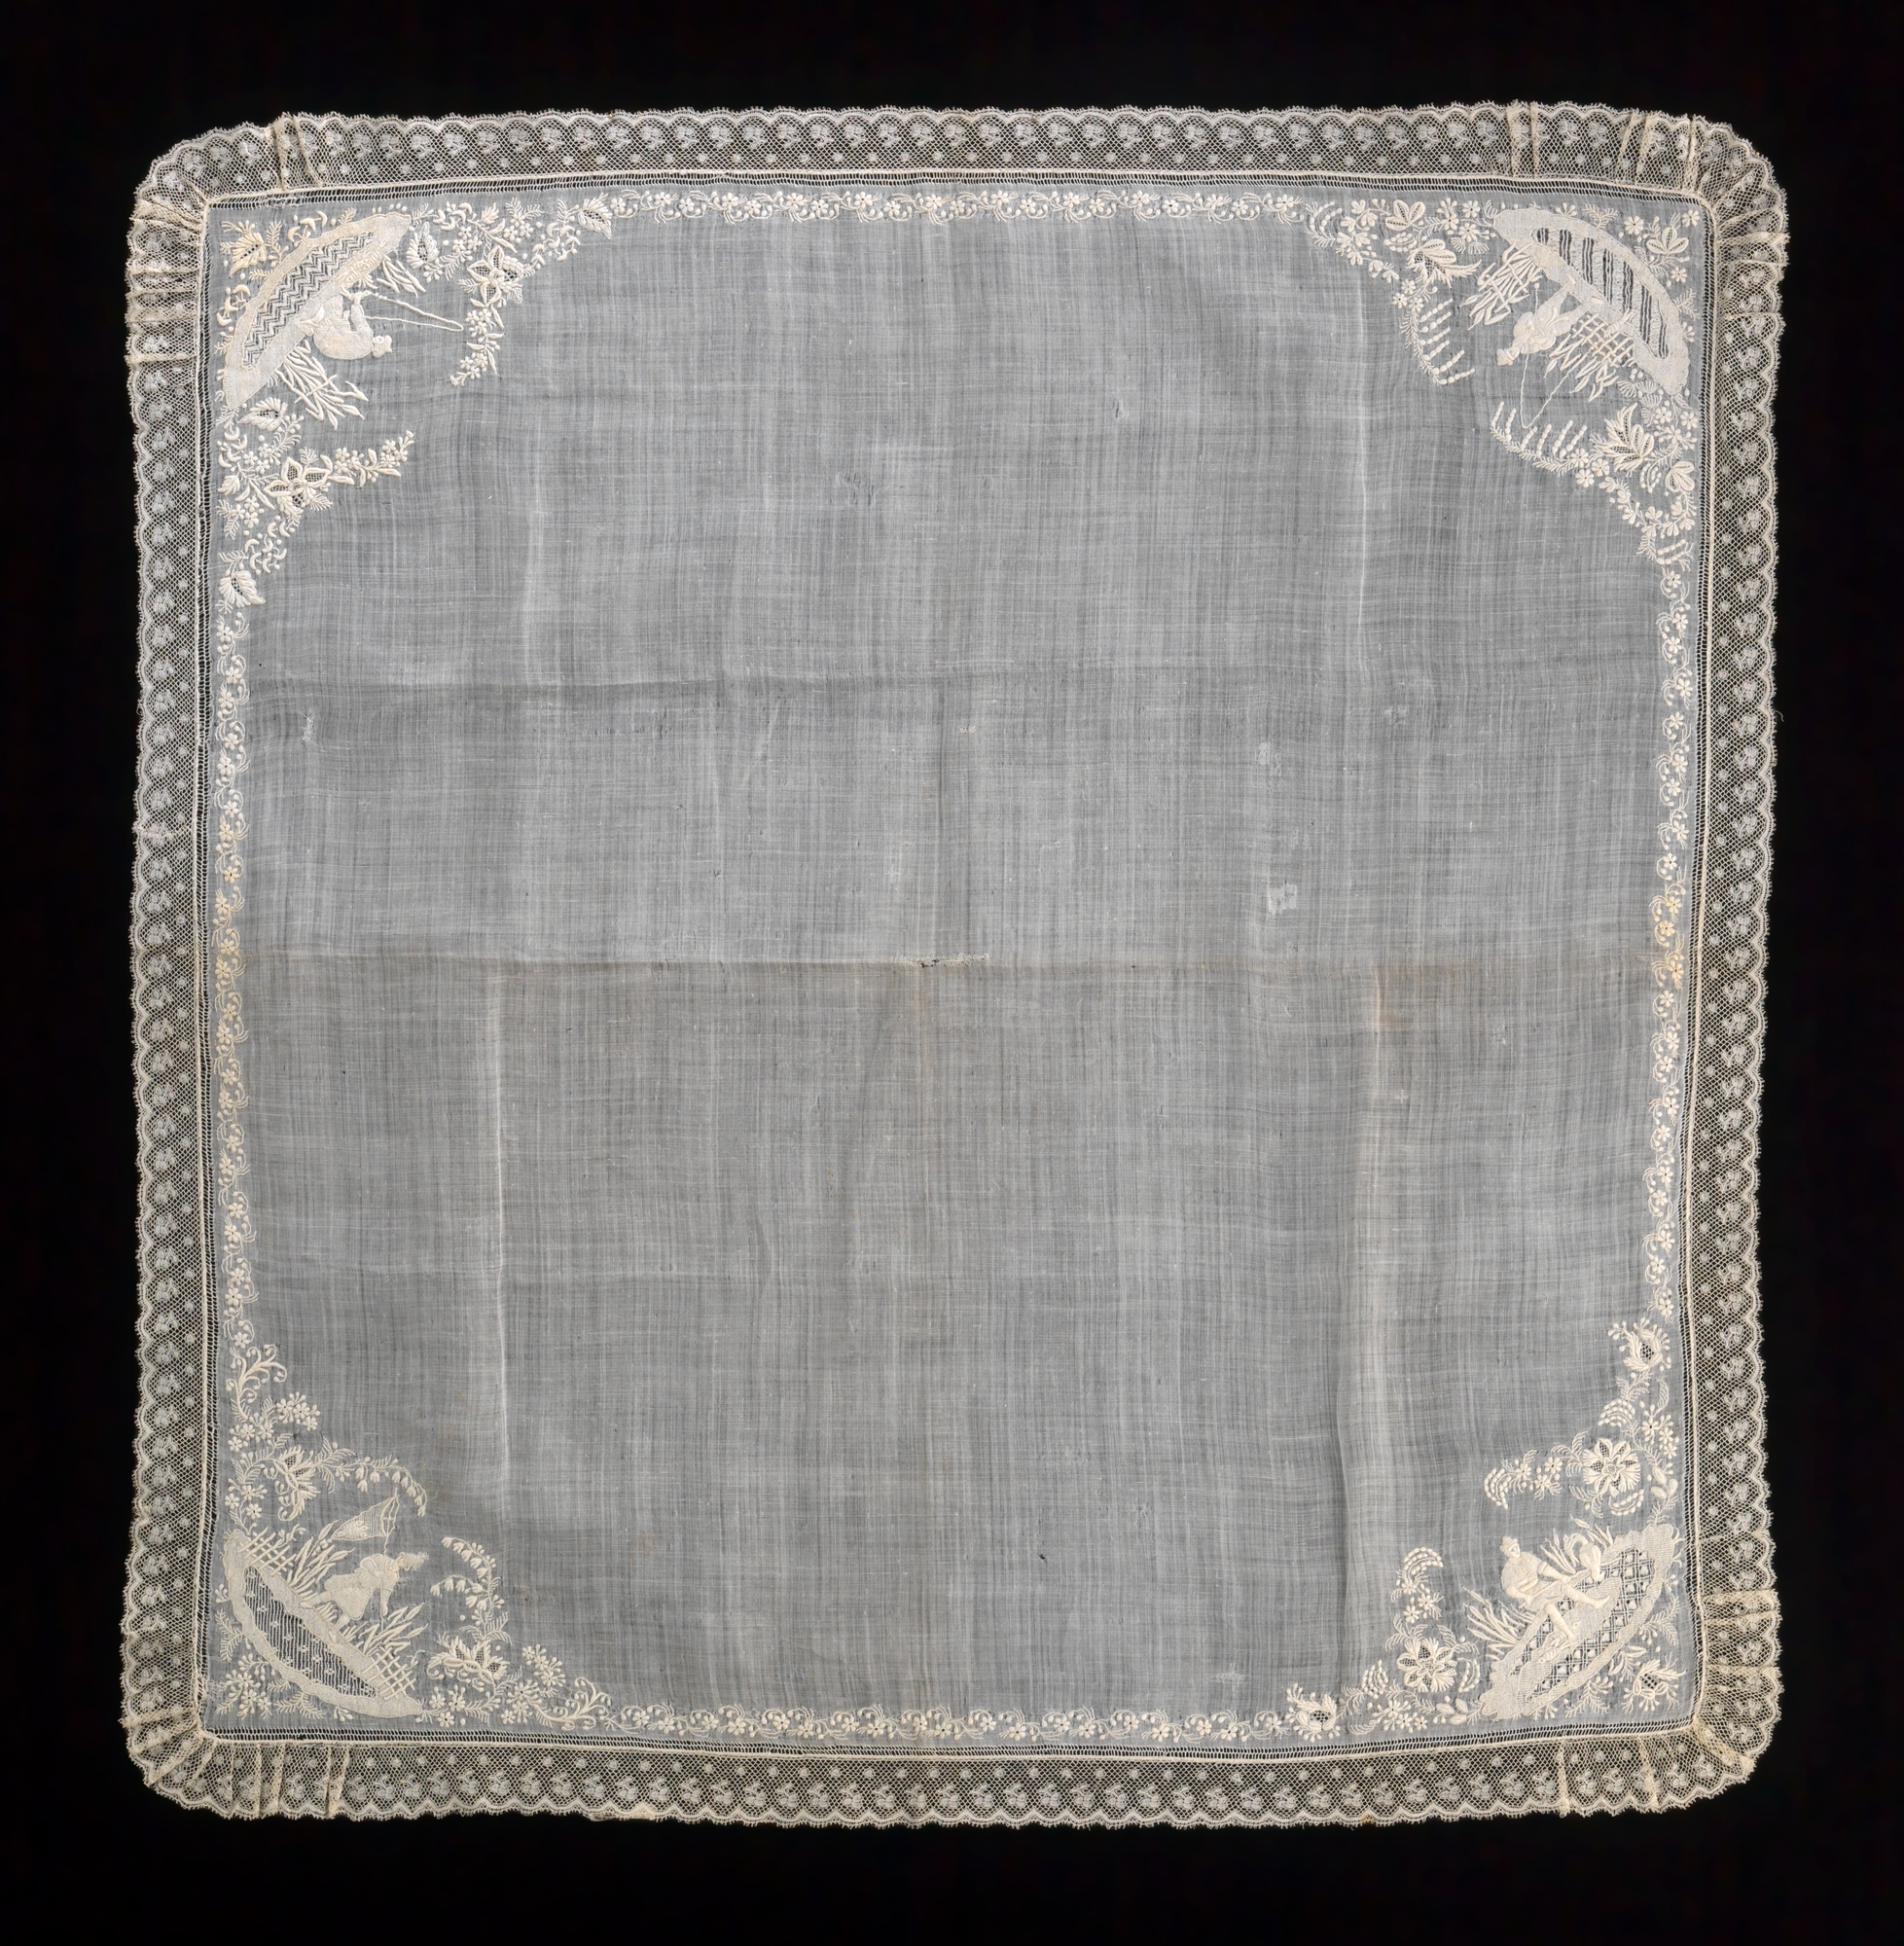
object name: handkerchief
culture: french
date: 1776-1800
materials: linen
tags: men,fishing